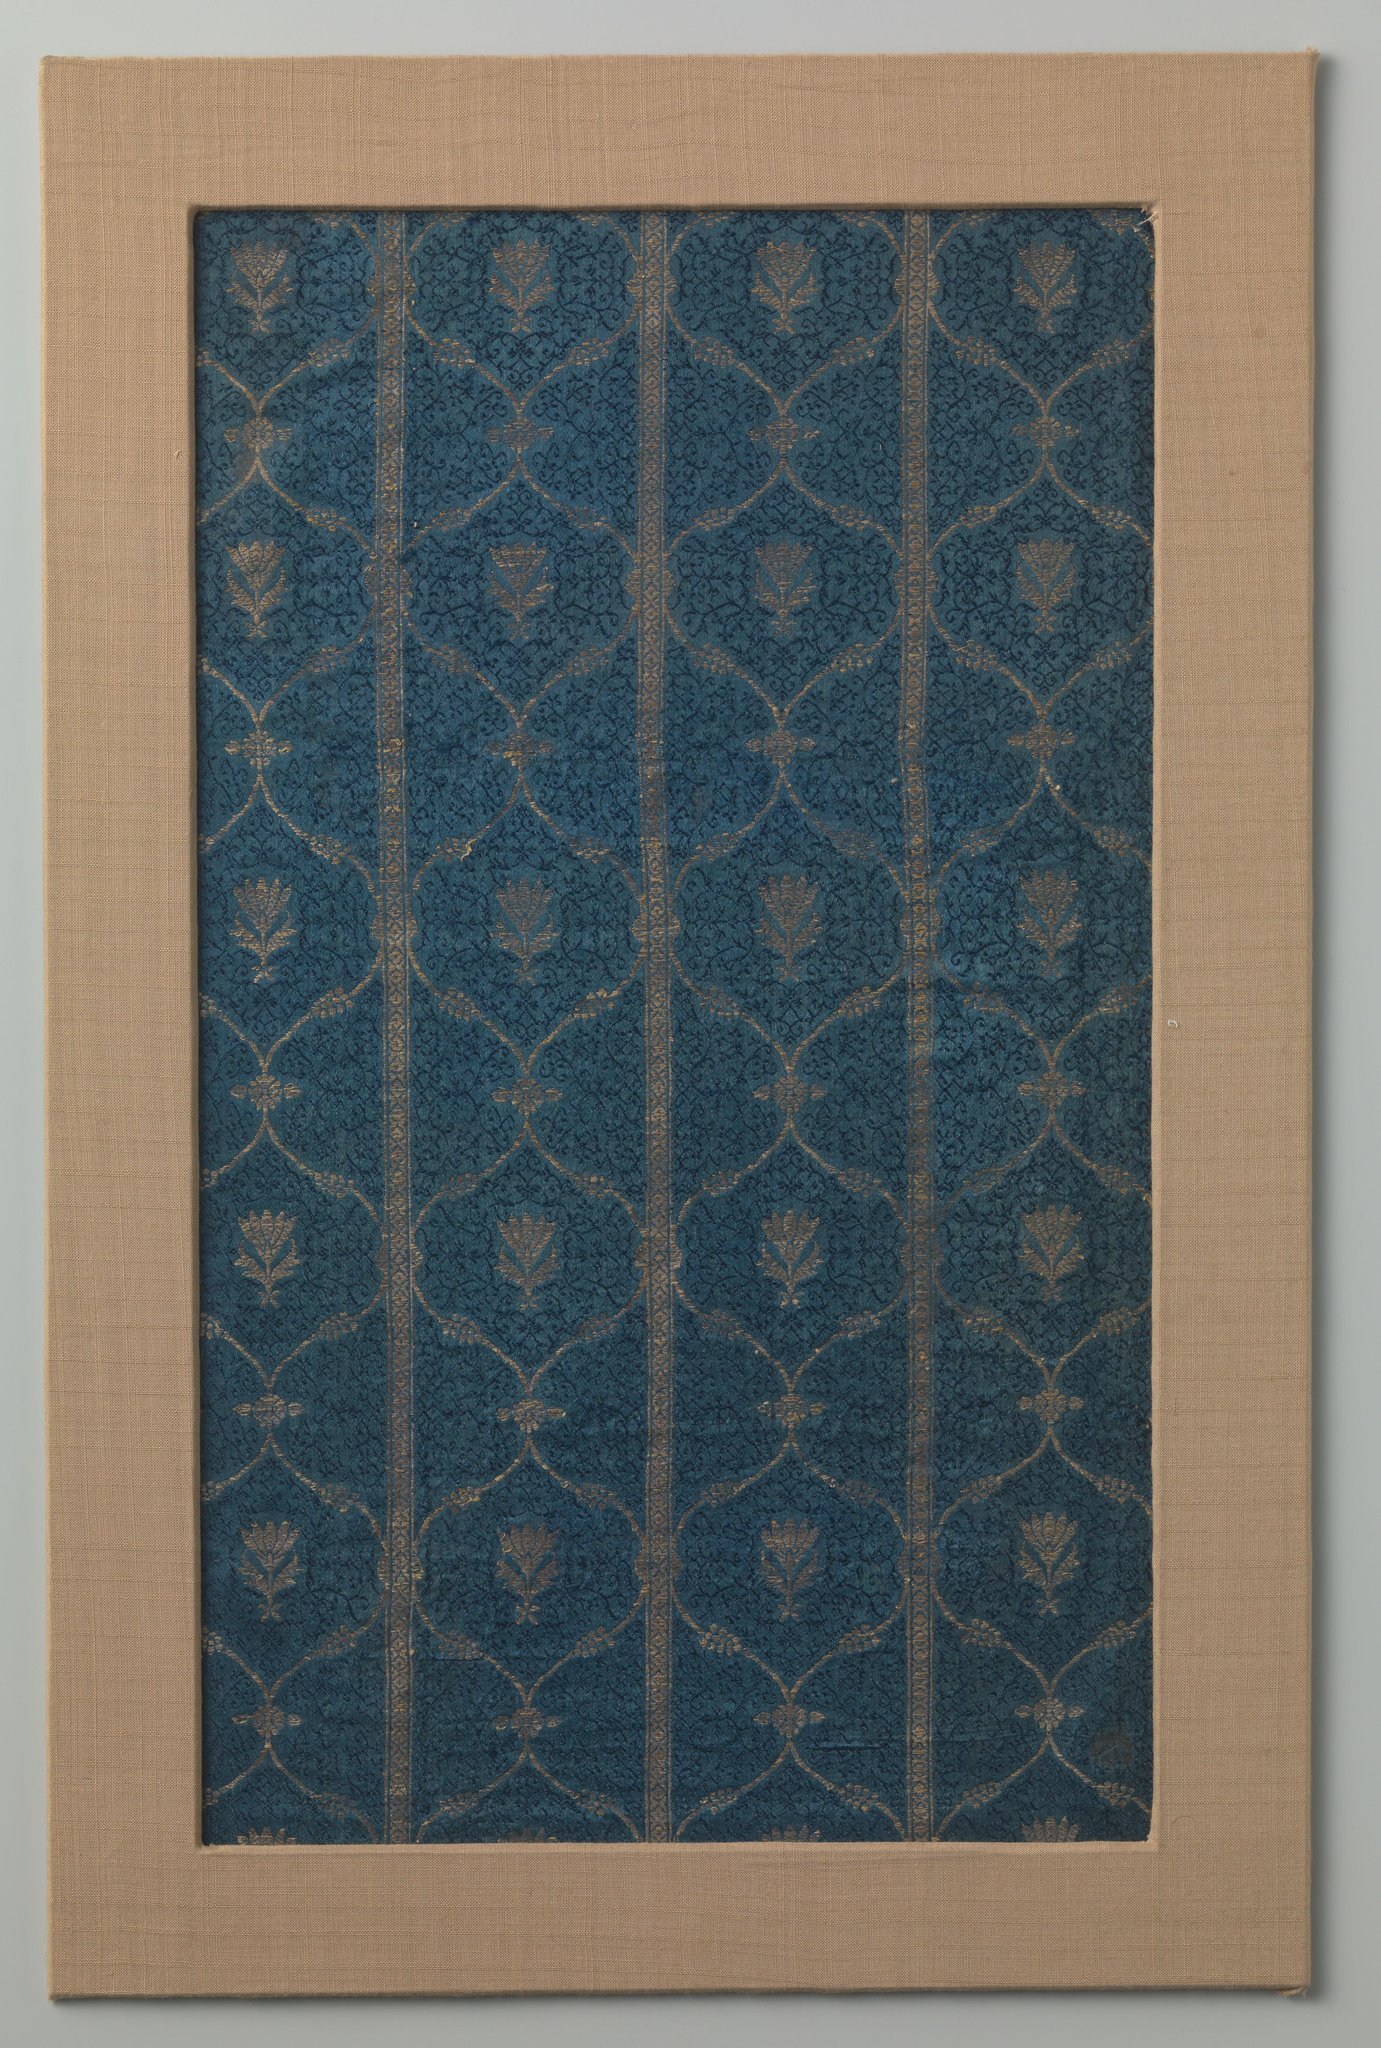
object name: zijdesatijn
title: Fragment zijdesatijn met patroon in gouddraad van verticale banen voorzien van met elkaar verbonden spitsovalen die alle een bloemfiguur in het midden hebben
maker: Anonymous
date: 1500-1599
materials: silk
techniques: brocade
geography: iran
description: Fragment met patroon in gouddraad van verticale banen voorzien van met elkaar verbonden spitsovalen die alle een bloemfiguur in het midden hebben.